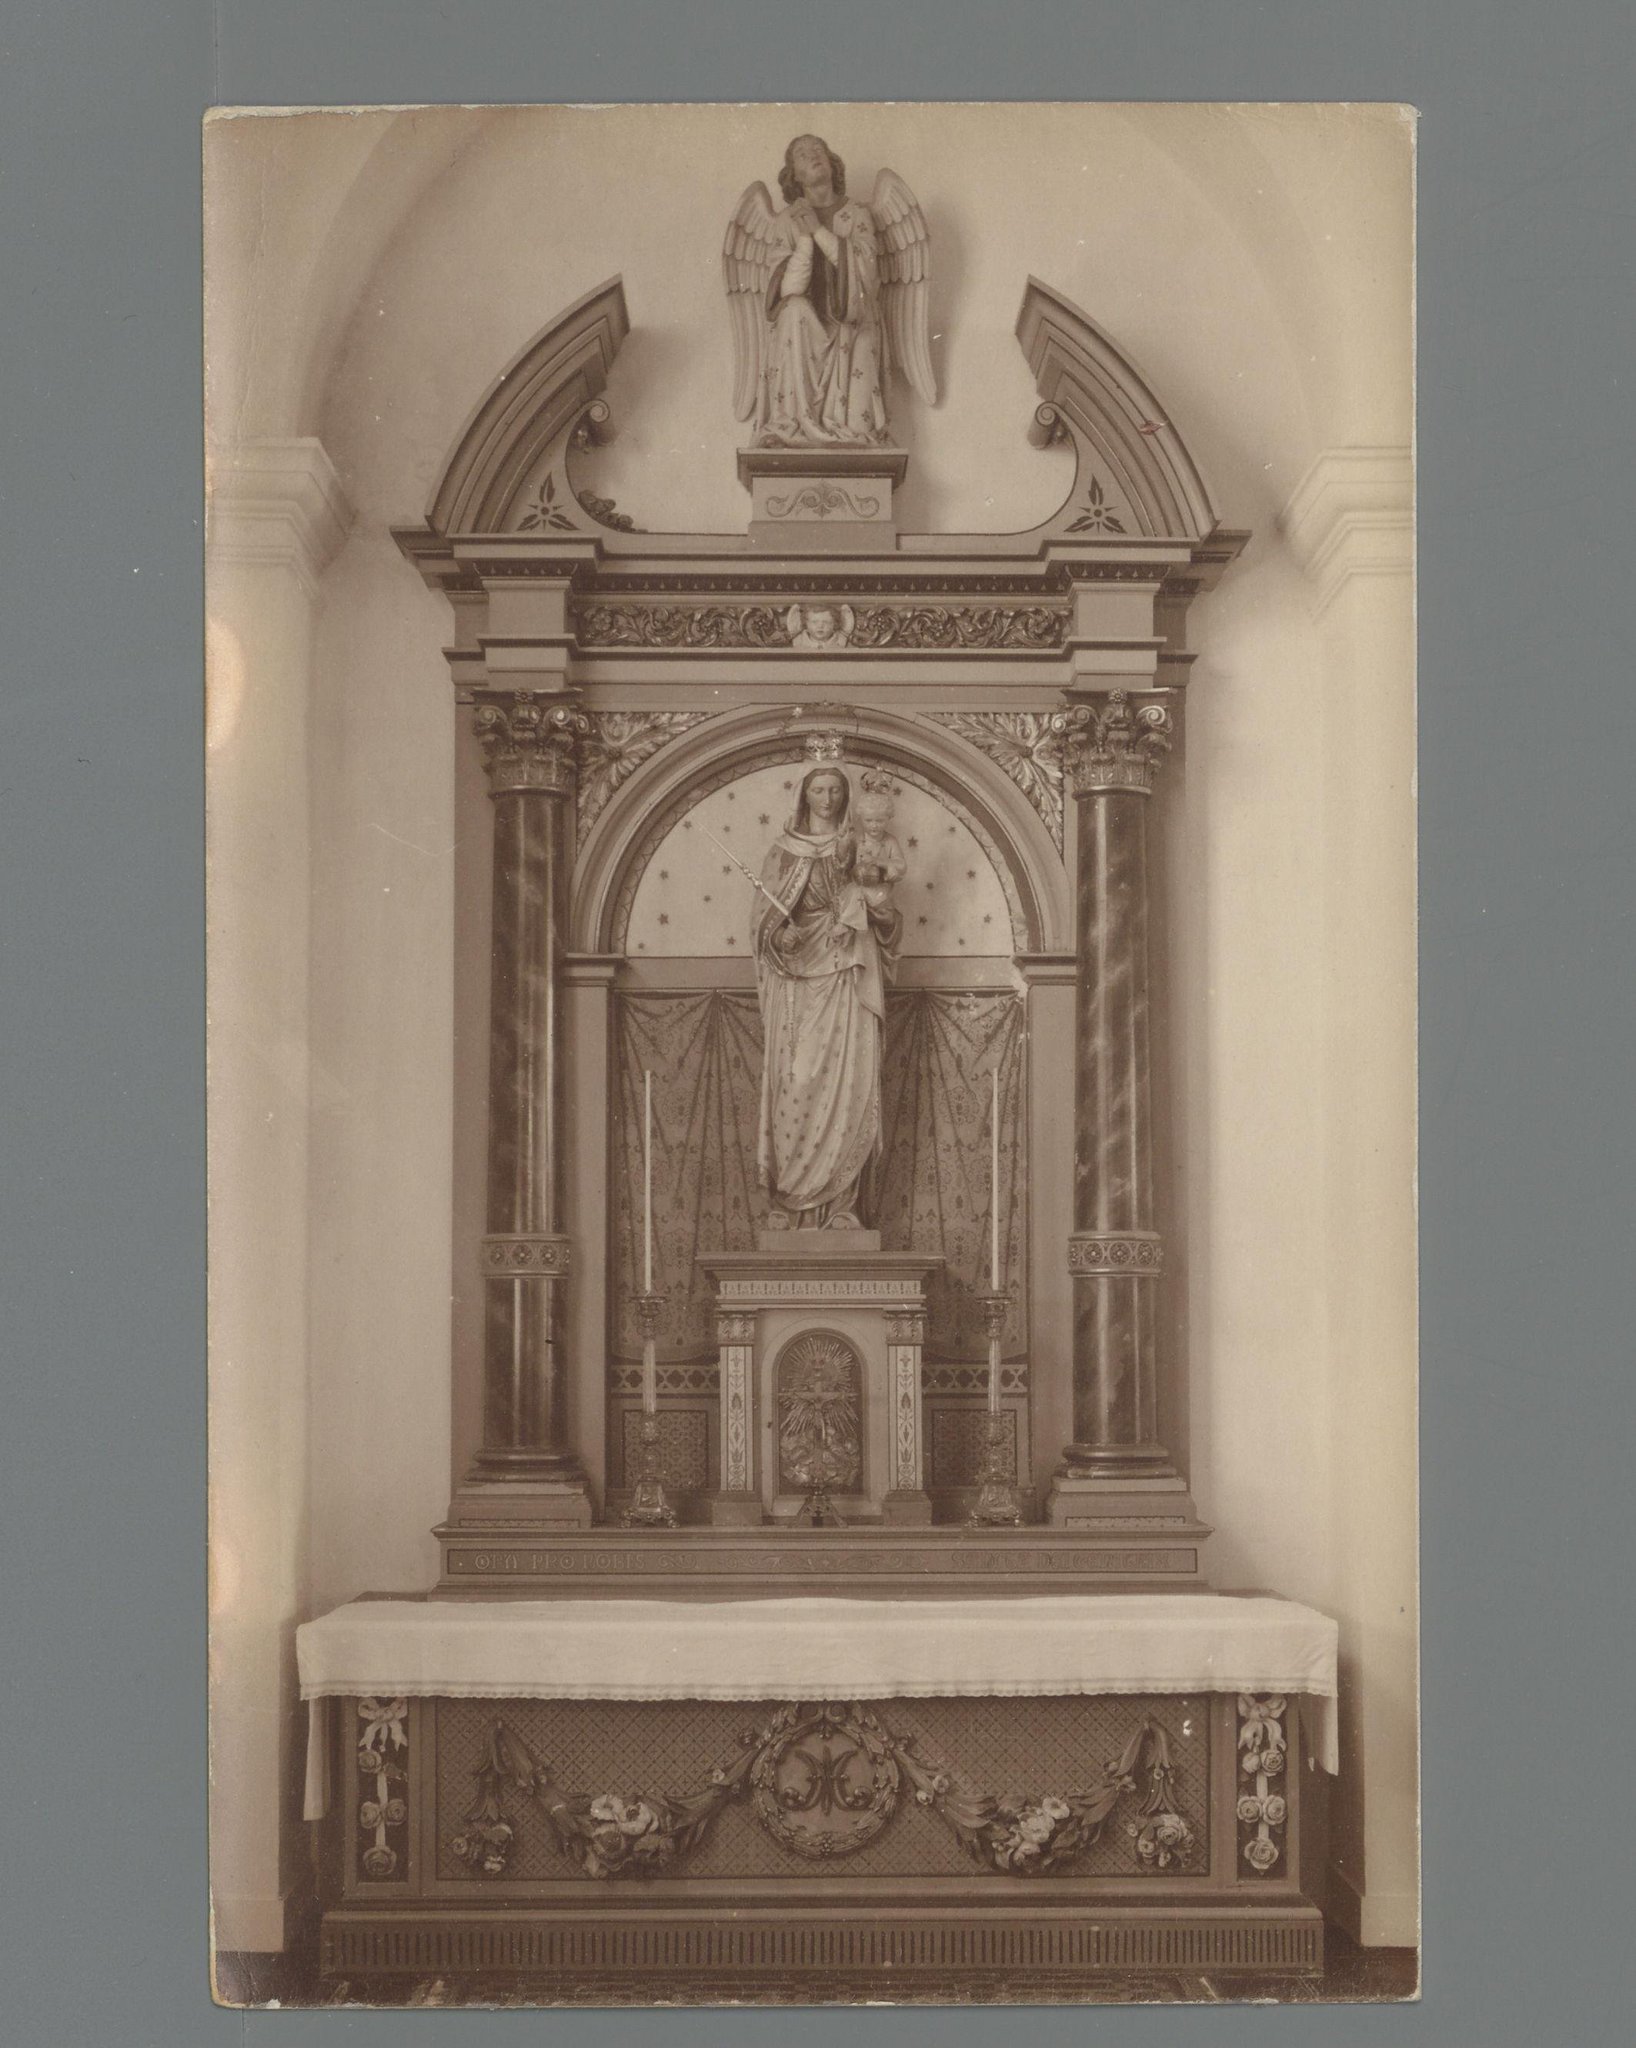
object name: ansichtkaart, prentbriefkaart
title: Mariabeeld in een kerk te Edam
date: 1906-1931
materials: photographic support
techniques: collodion silver print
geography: edam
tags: madonna: i.e. mary with the christ-child, interior of church, monument, statue, vault ~ architecture